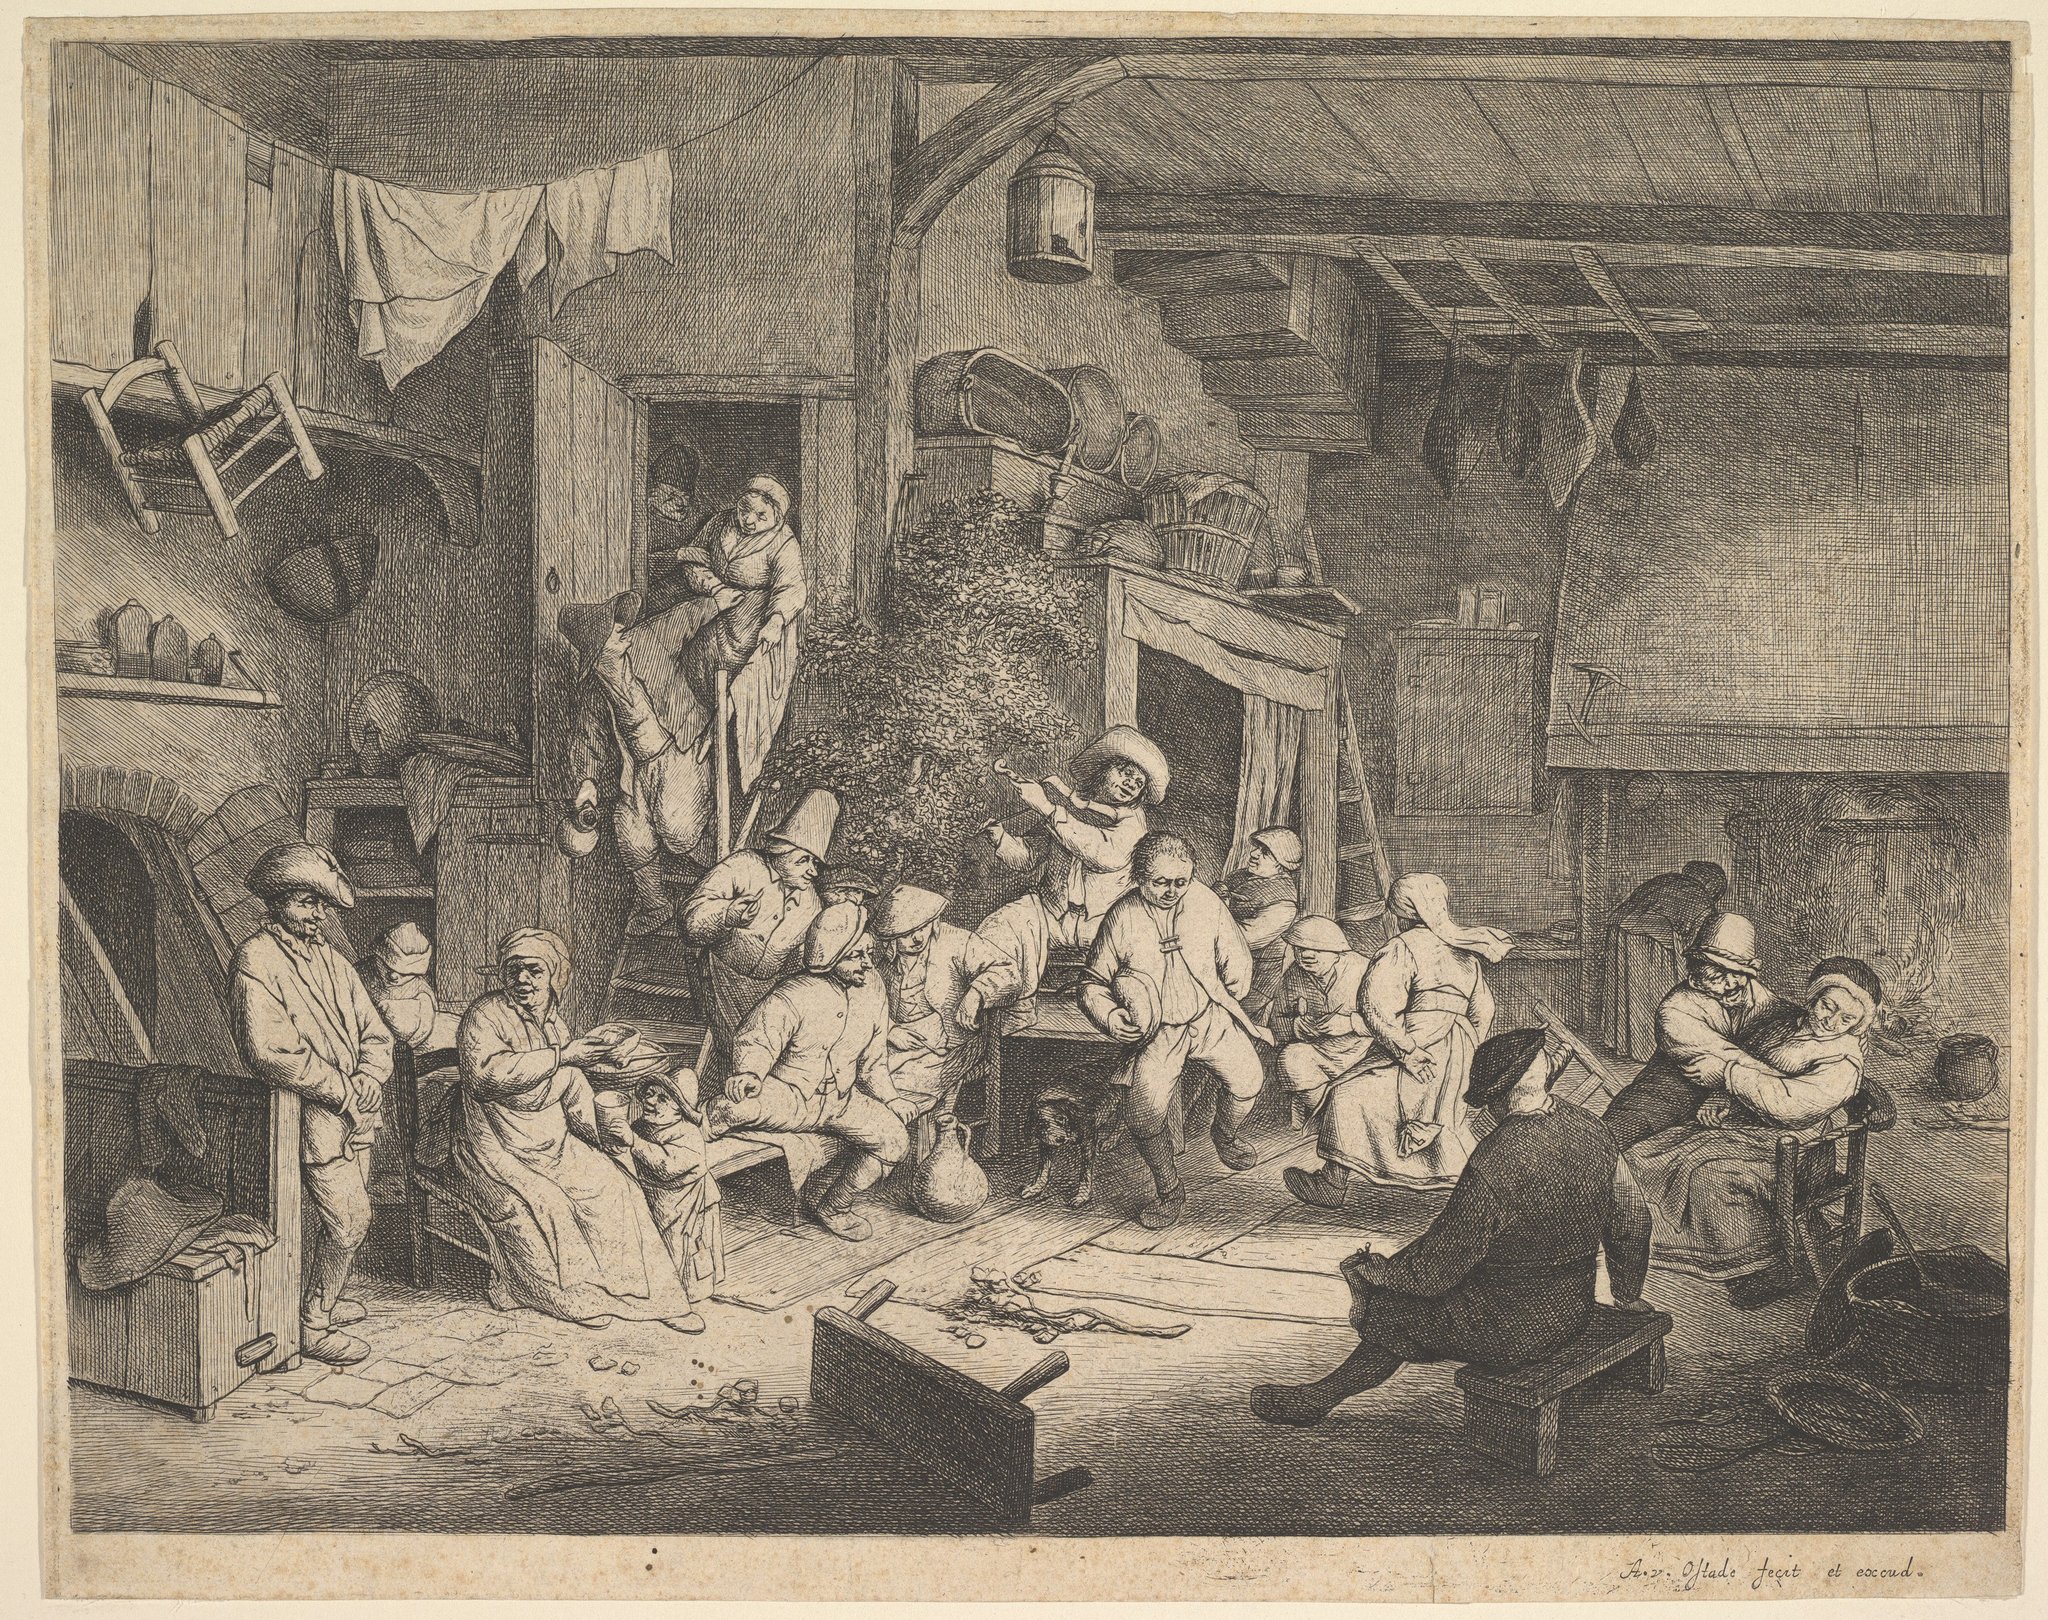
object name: print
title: The Dance at the Inn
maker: adriaen van ostade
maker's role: artist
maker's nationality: dutch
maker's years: 1610-1685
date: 1652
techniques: etching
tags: inns,interiors,men,women,dancing